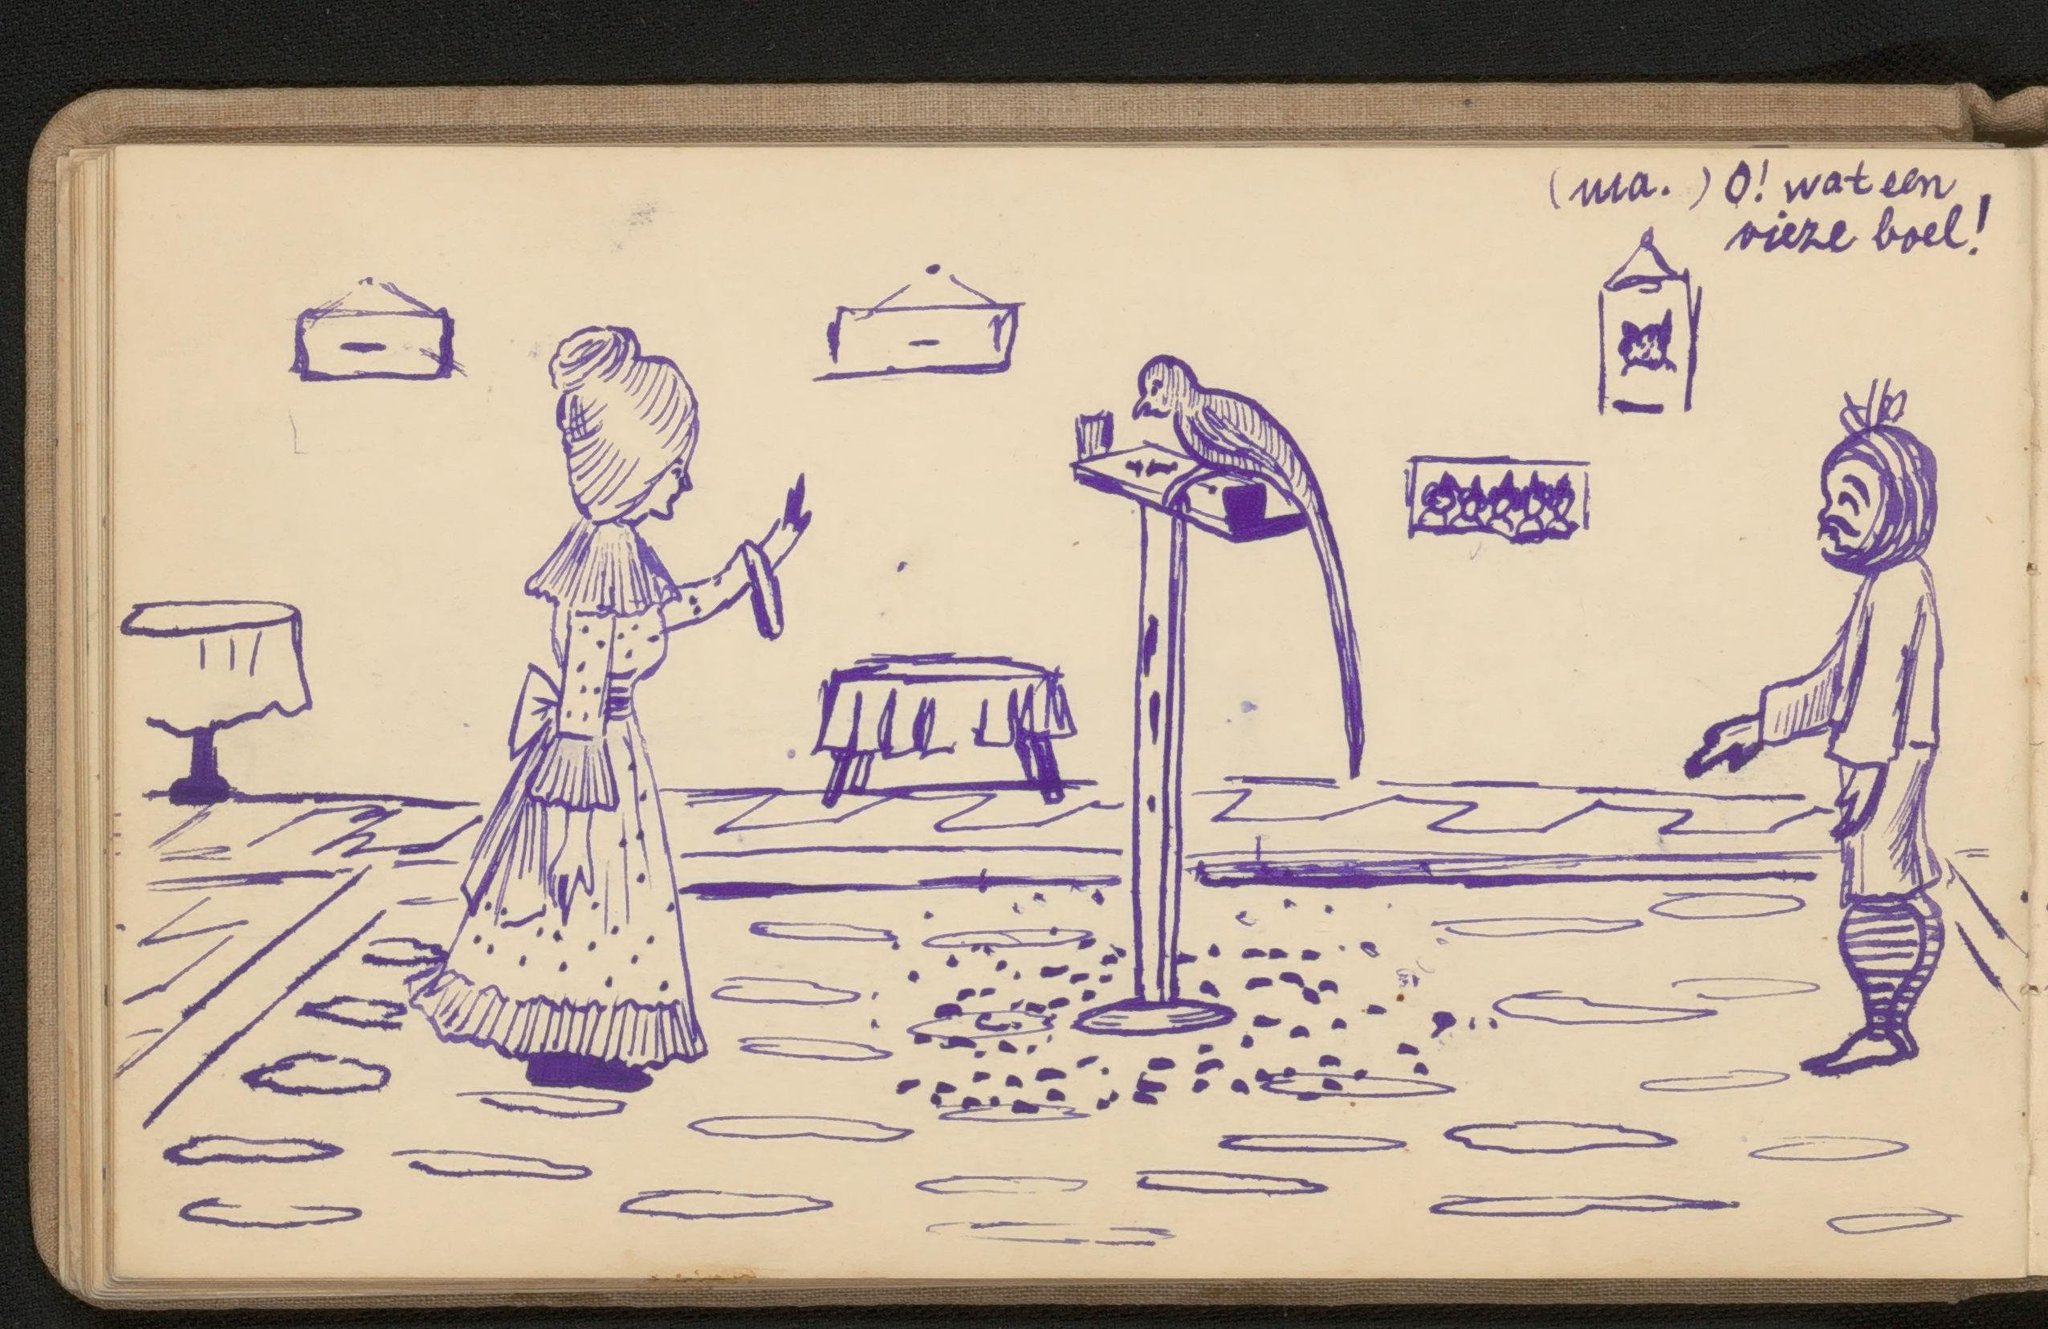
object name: sketchbook leaf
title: Papegaai in de kamer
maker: Anonymous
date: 1875-1920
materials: ink, paper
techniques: pen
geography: netherlands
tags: ornamental birds: parrot, family life at home, living-room, parlour, sitting-room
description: De aangeschafte papegaai maakt een vieze boel in de kamer. Onderdeel van het schetsboek met humoristische tekeningen over het leven van een 'famille nombreuse'. Onderwerpsrubrieken binnen de Atlas Zeden en Gewoonten: Zeden en Gewoonten in Engeren Zin, Des menschen beging, midden en einde, Kinderleven.